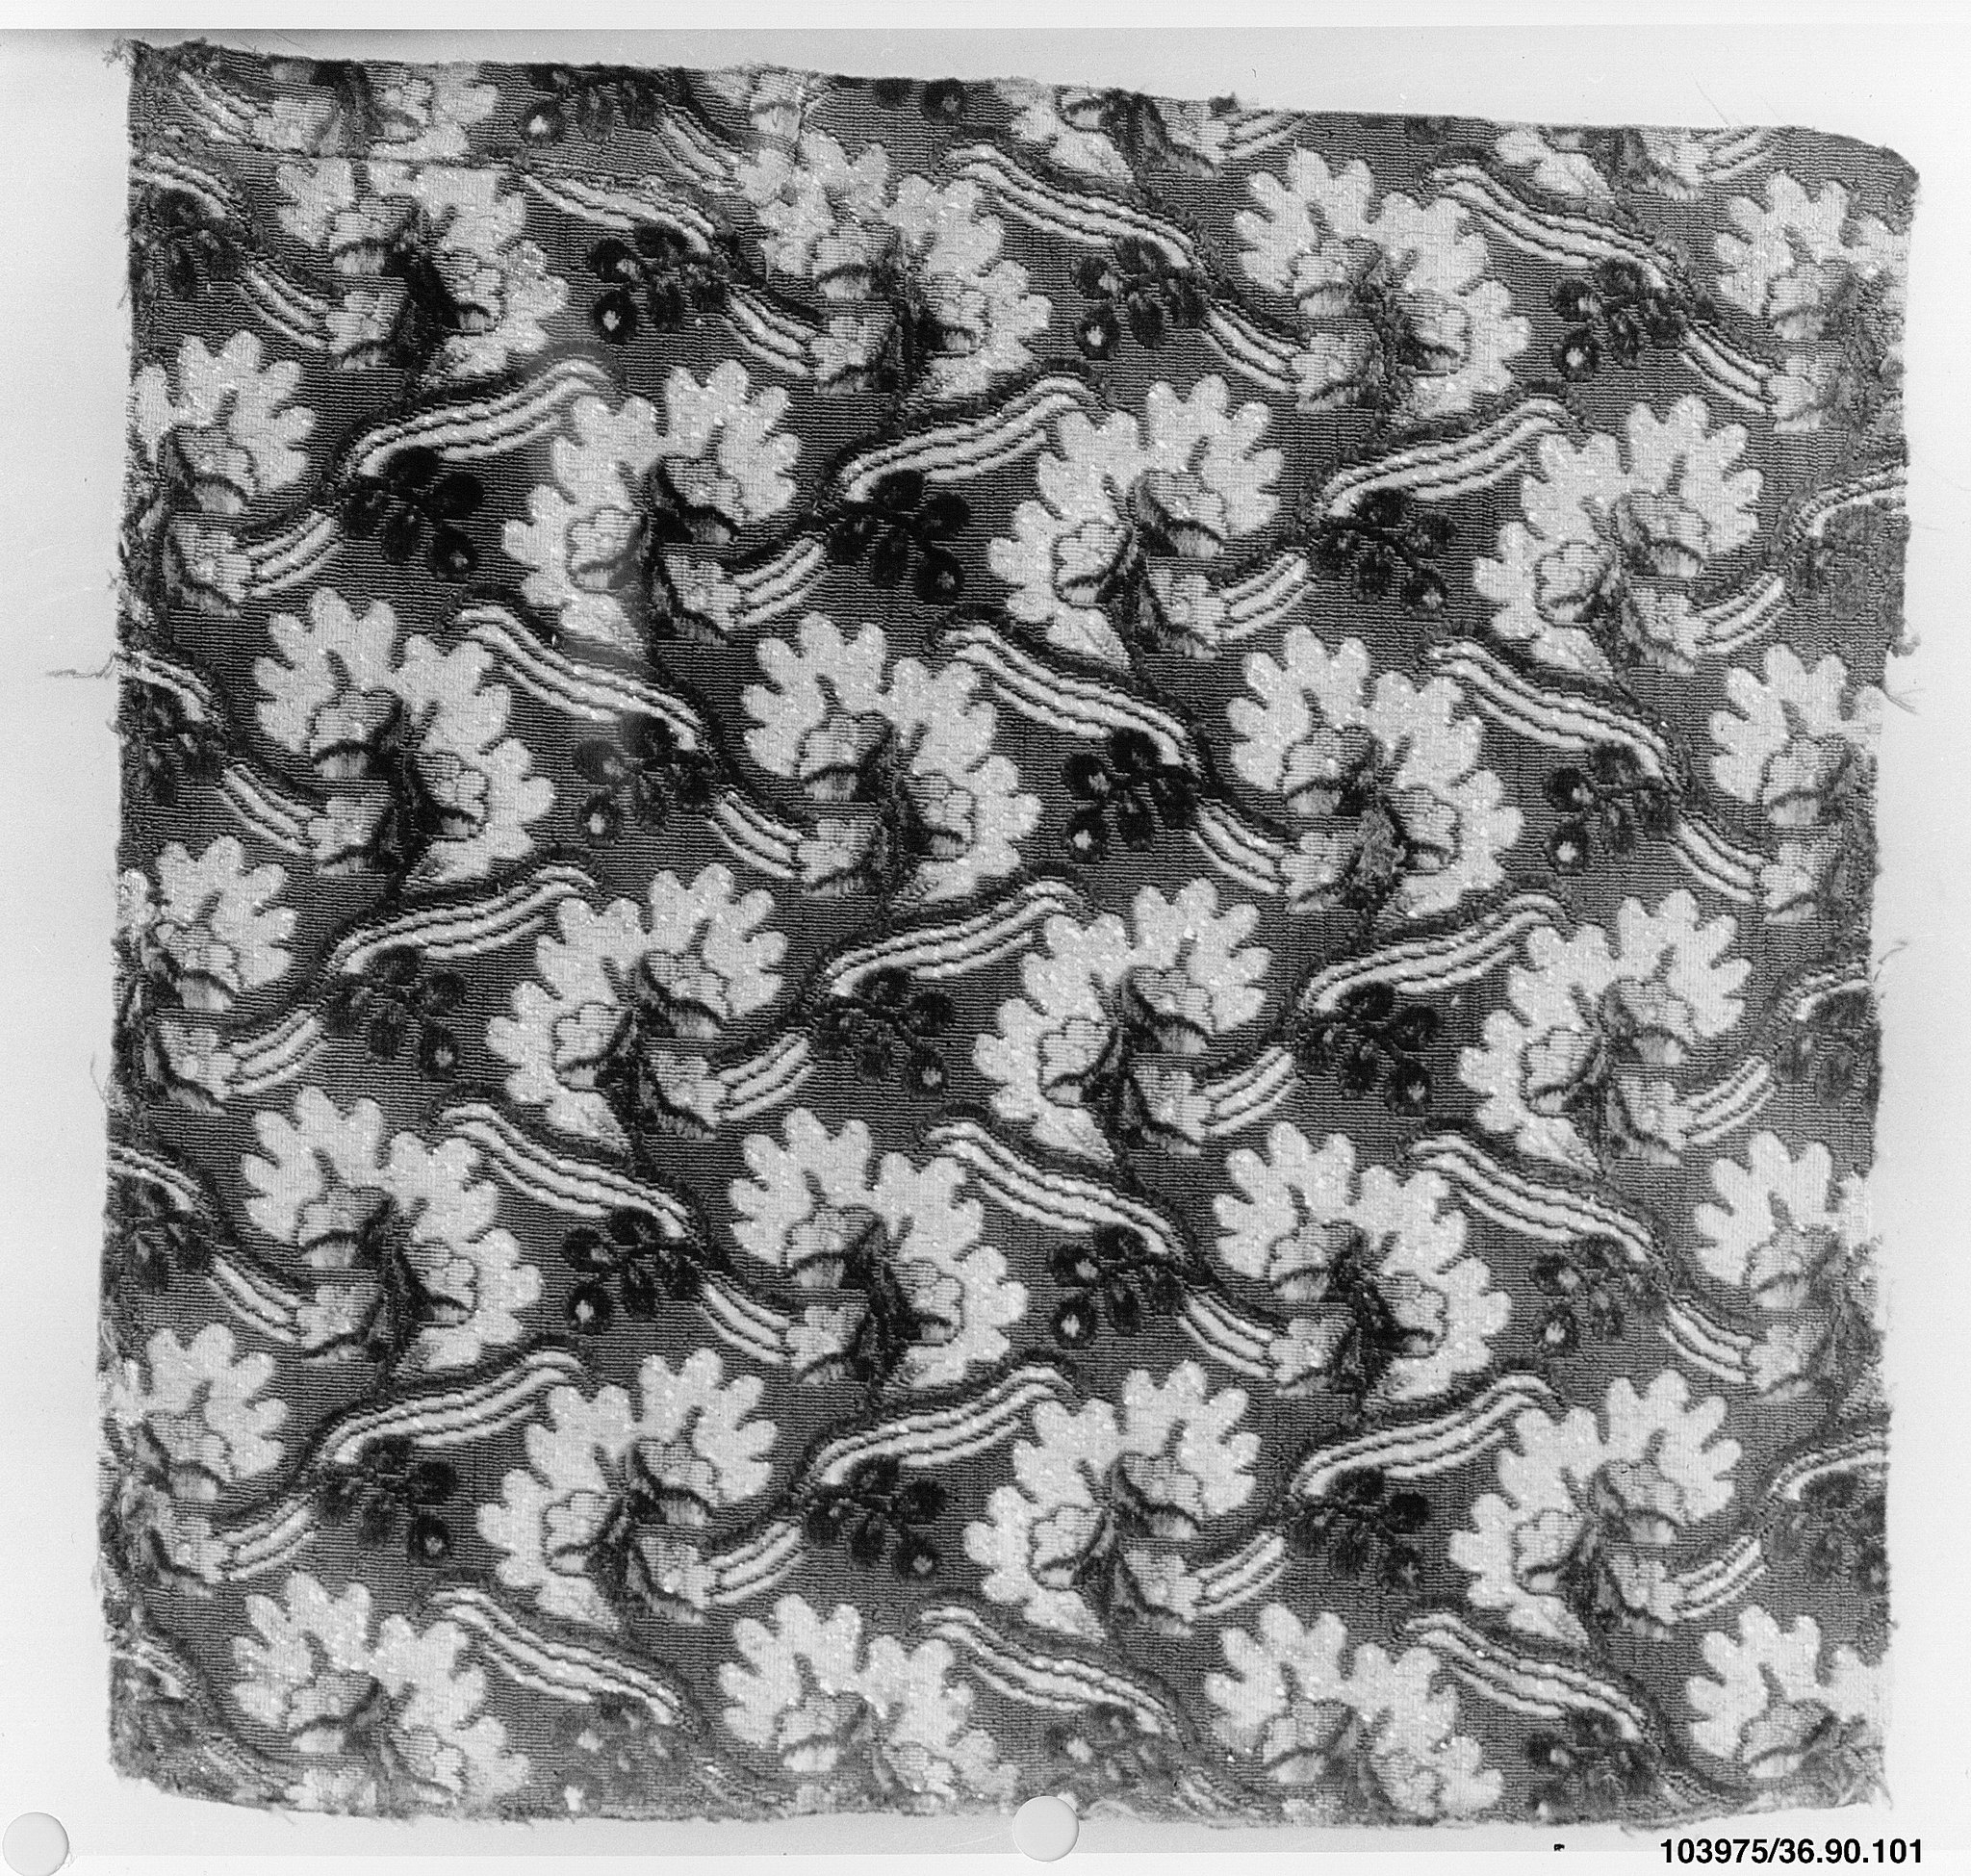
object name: piece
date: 1767-1800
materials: metal thread, silk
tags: flowers